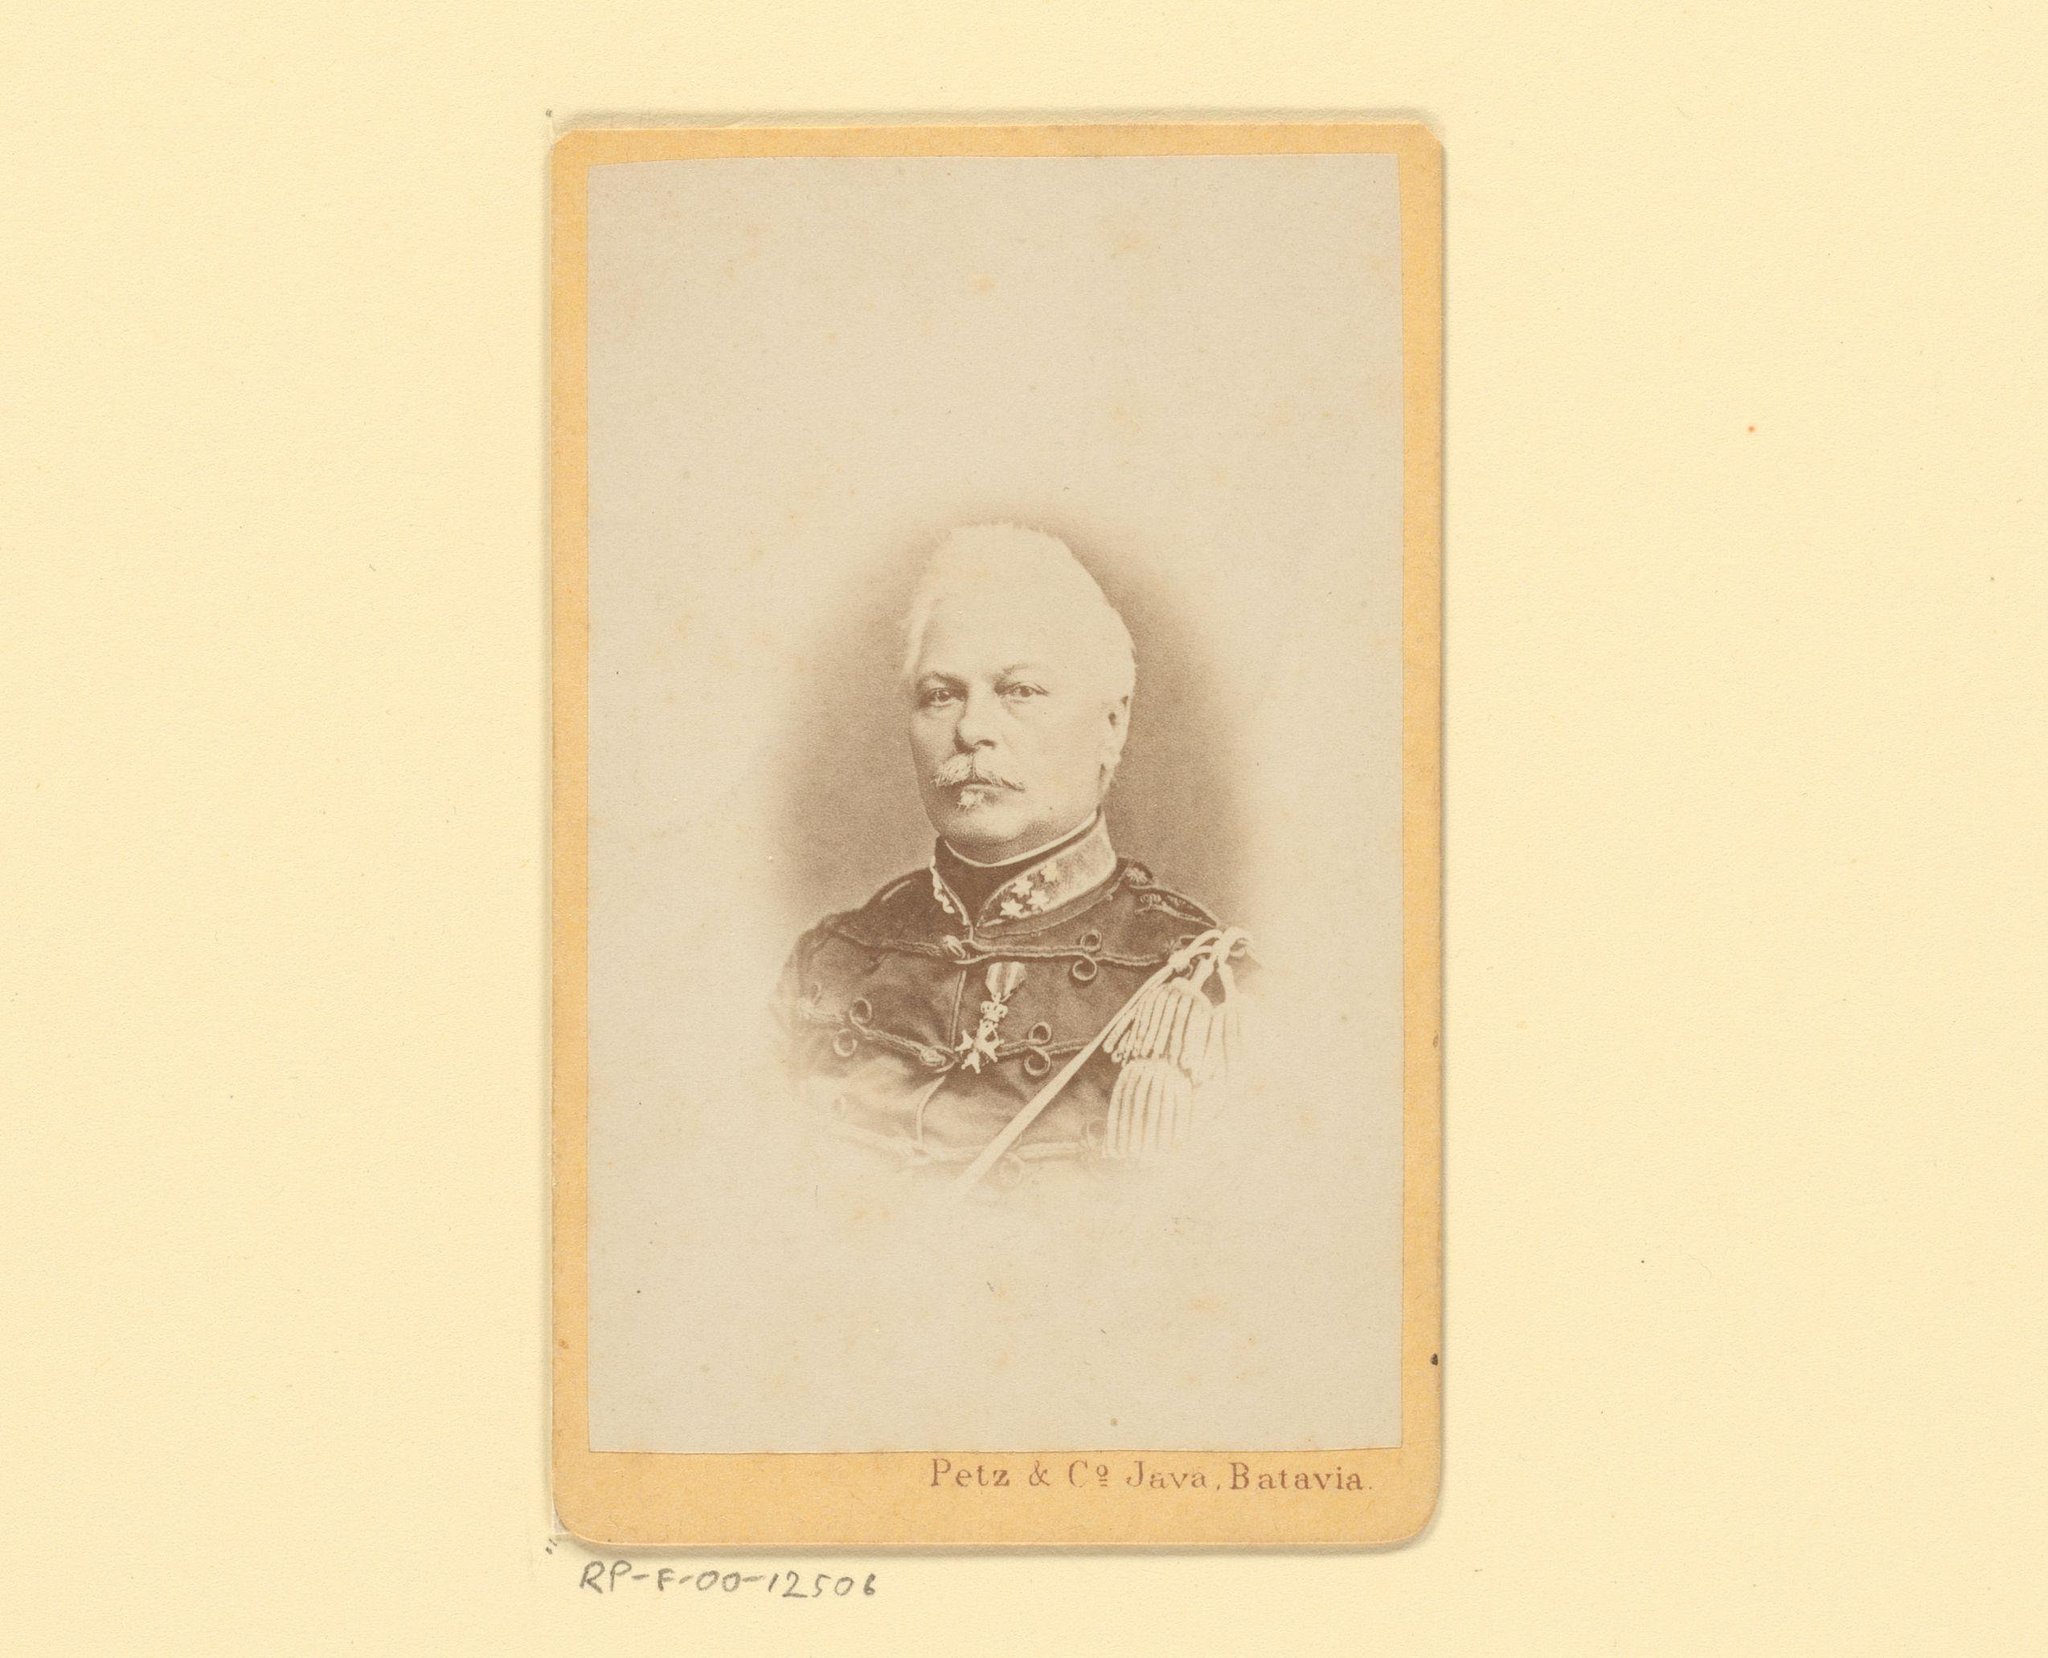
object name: carte de visite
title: Portret van generaal Johan Harmen Rudolf Köhler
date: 1871-1890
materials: cardboard, paper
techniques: albumen print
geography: batavia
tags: historical persons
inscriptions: inscription: ‘Portretten in elke grootte & genre/ Nabestellingen worden zelfs na/ verloop van jaren geeffectueerd.’